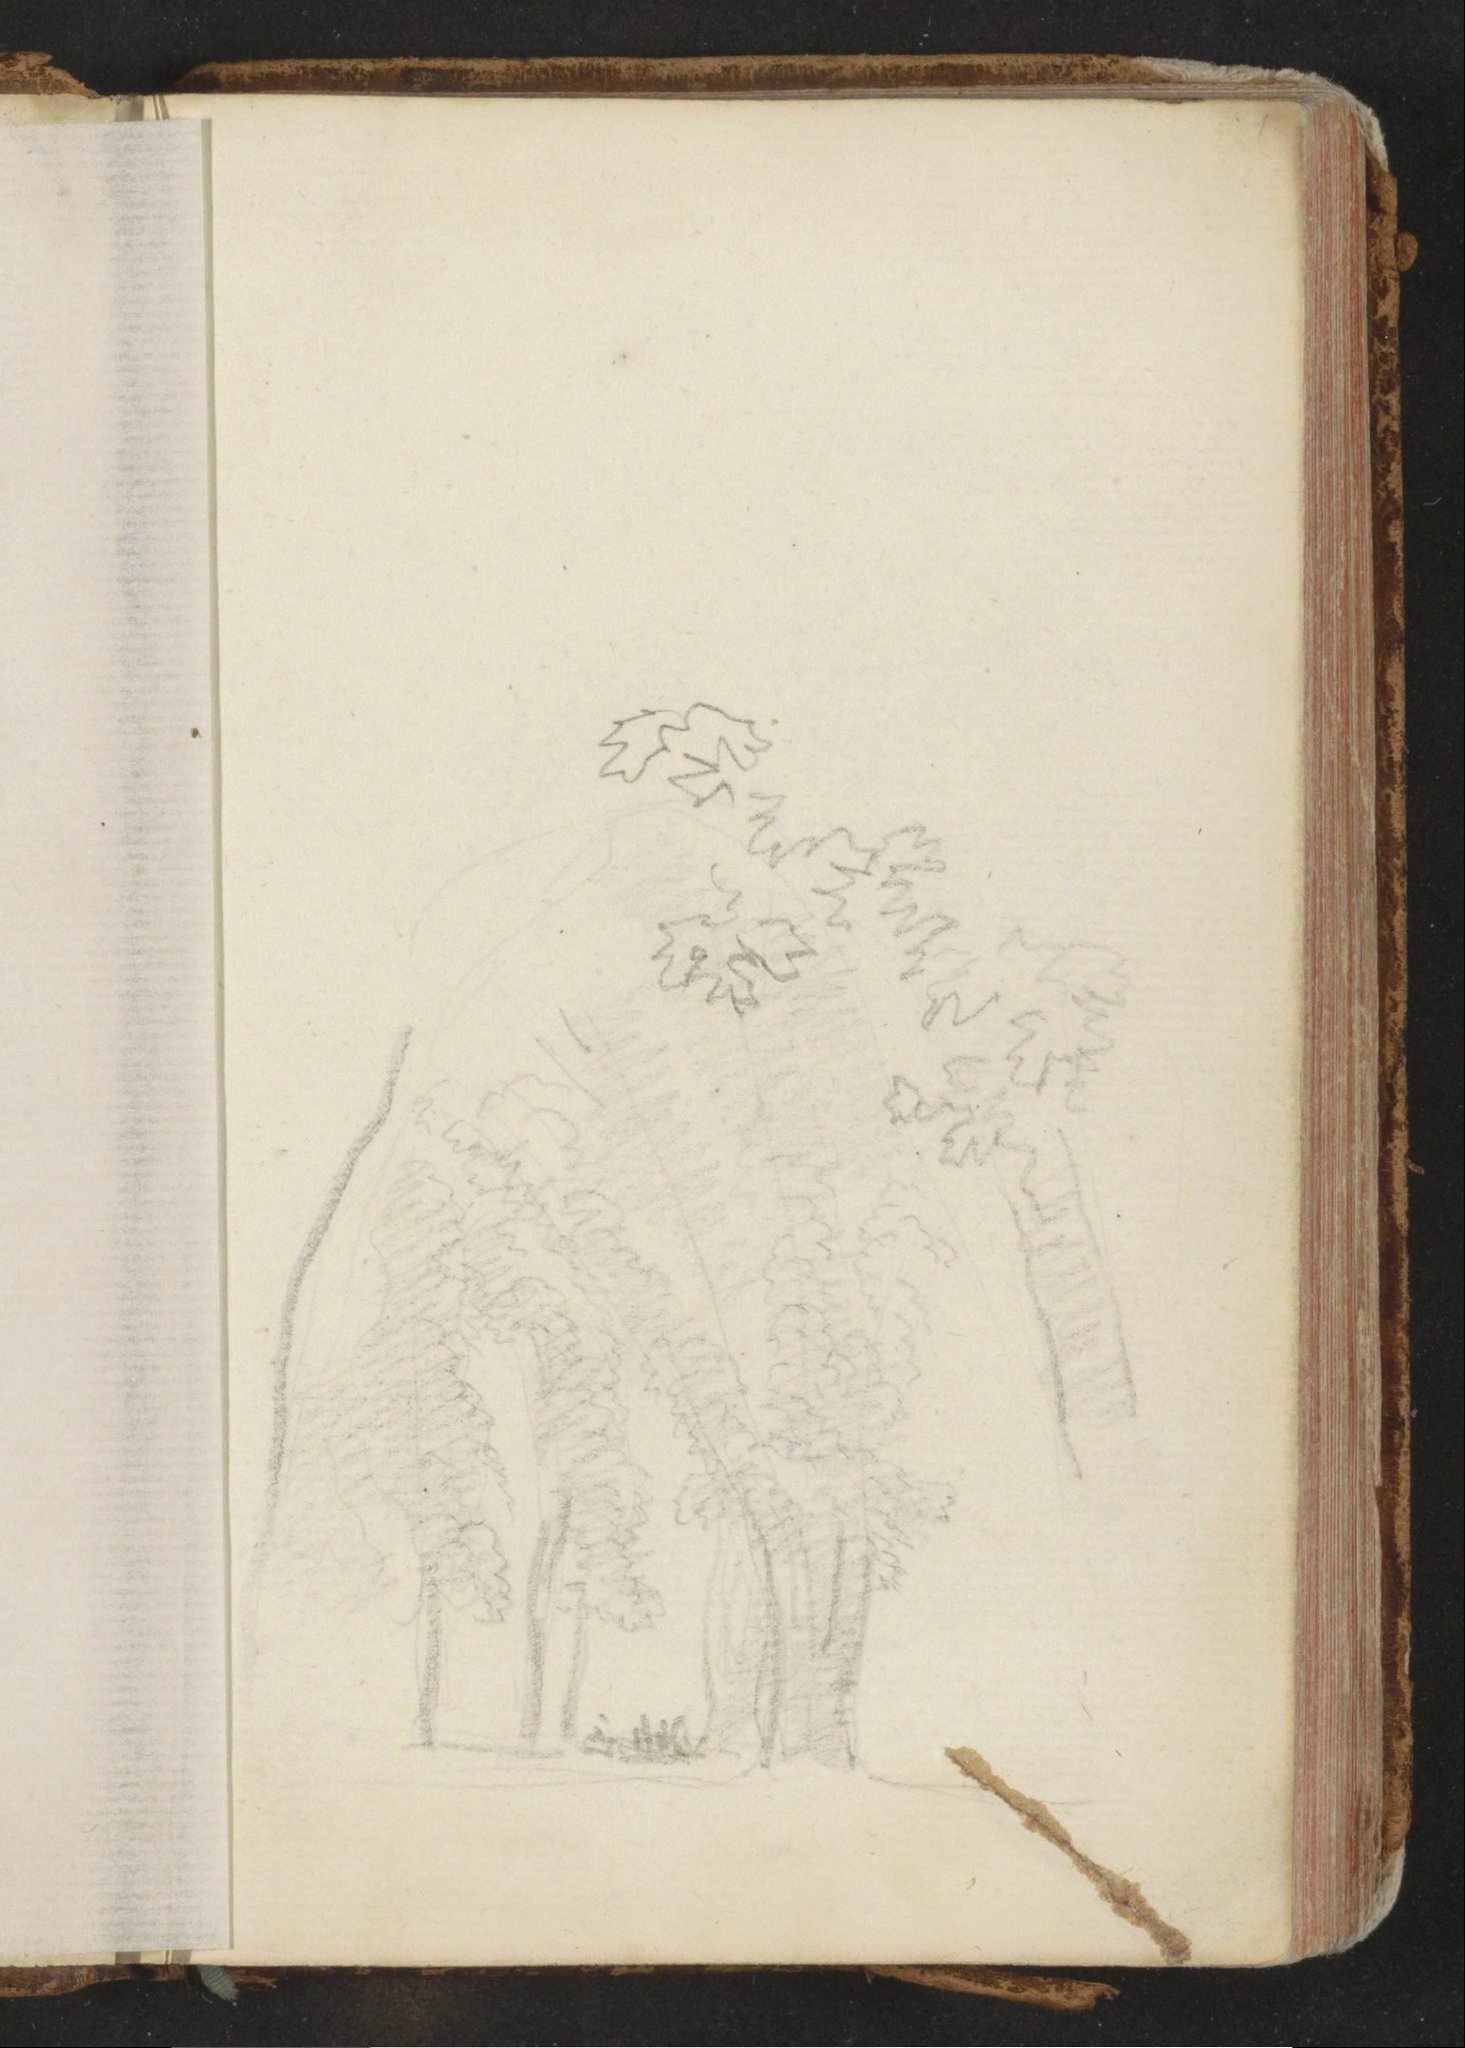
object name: sketchbook leaf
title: Bomen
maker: jean honoré fragonard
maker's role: draughtsman, painter, print maker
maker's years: 1732-1806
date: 1742-1806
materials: paper, pencil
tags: trees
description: Blad 1 recto uit een schetsboek met 83 bladen.